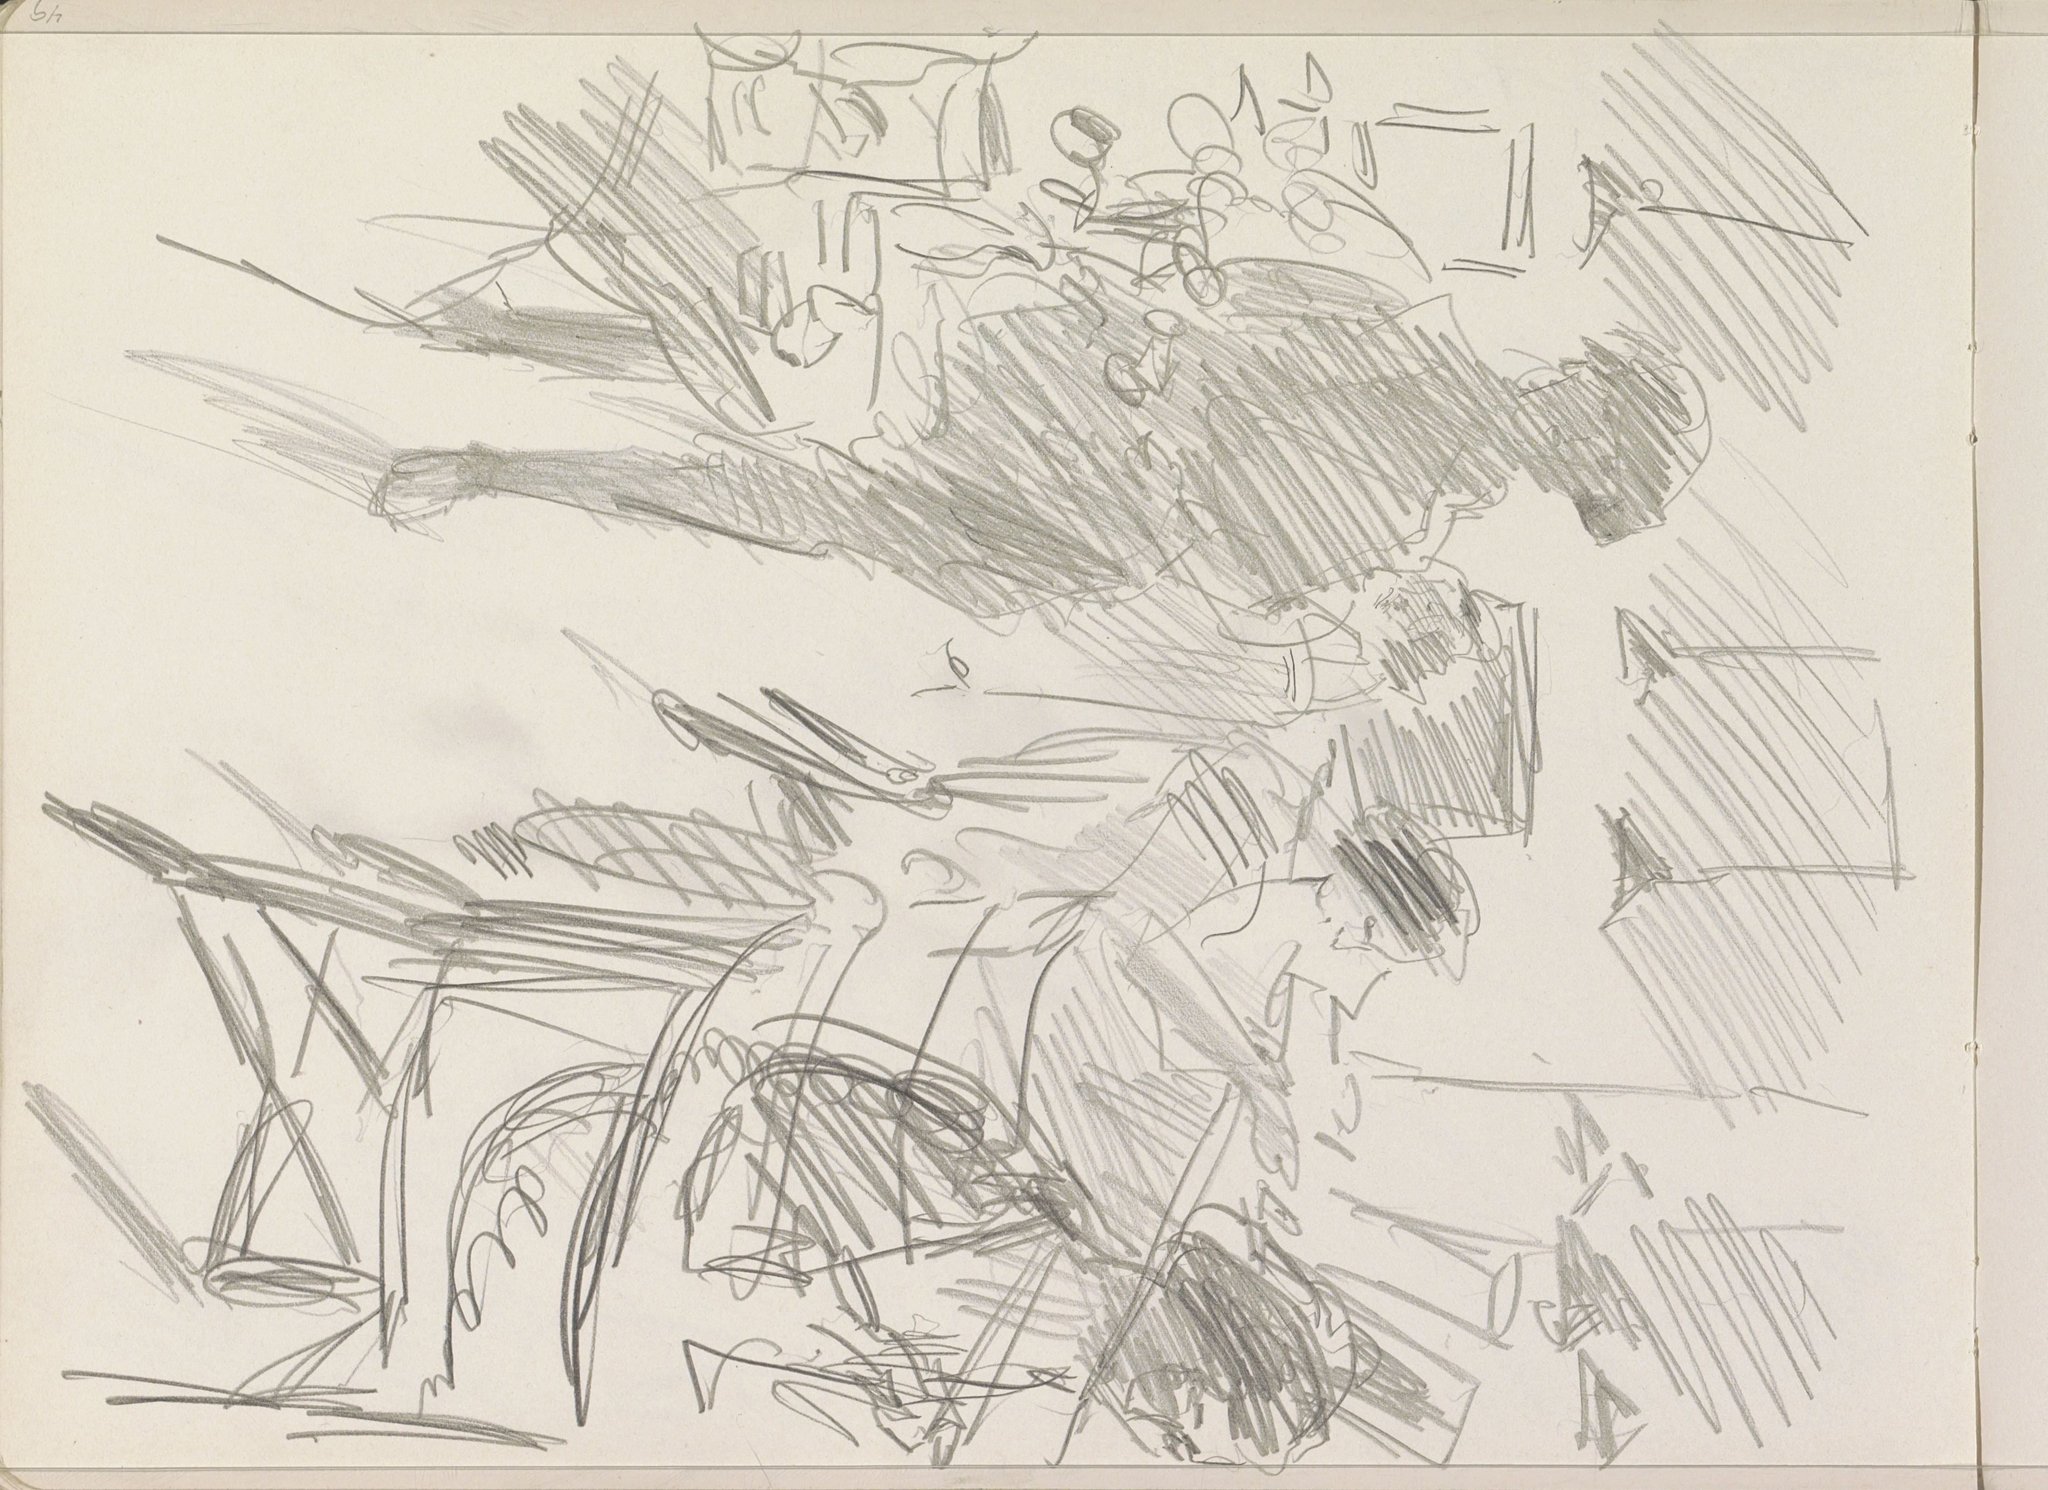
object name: sketchbook leaf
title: Vrouwen in een kleedkamer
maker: isaac israels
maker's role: draughtsman, painter, print maker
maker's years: 1865-1934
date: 1915-1934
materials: paper, pencil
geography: the hague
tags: dressing-room ~ stage, adult woman (+ four persons)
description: Mogelijk in Theater Scala te Den Haag. Blad 24 verso uit schetsboek III met 36 bladen.